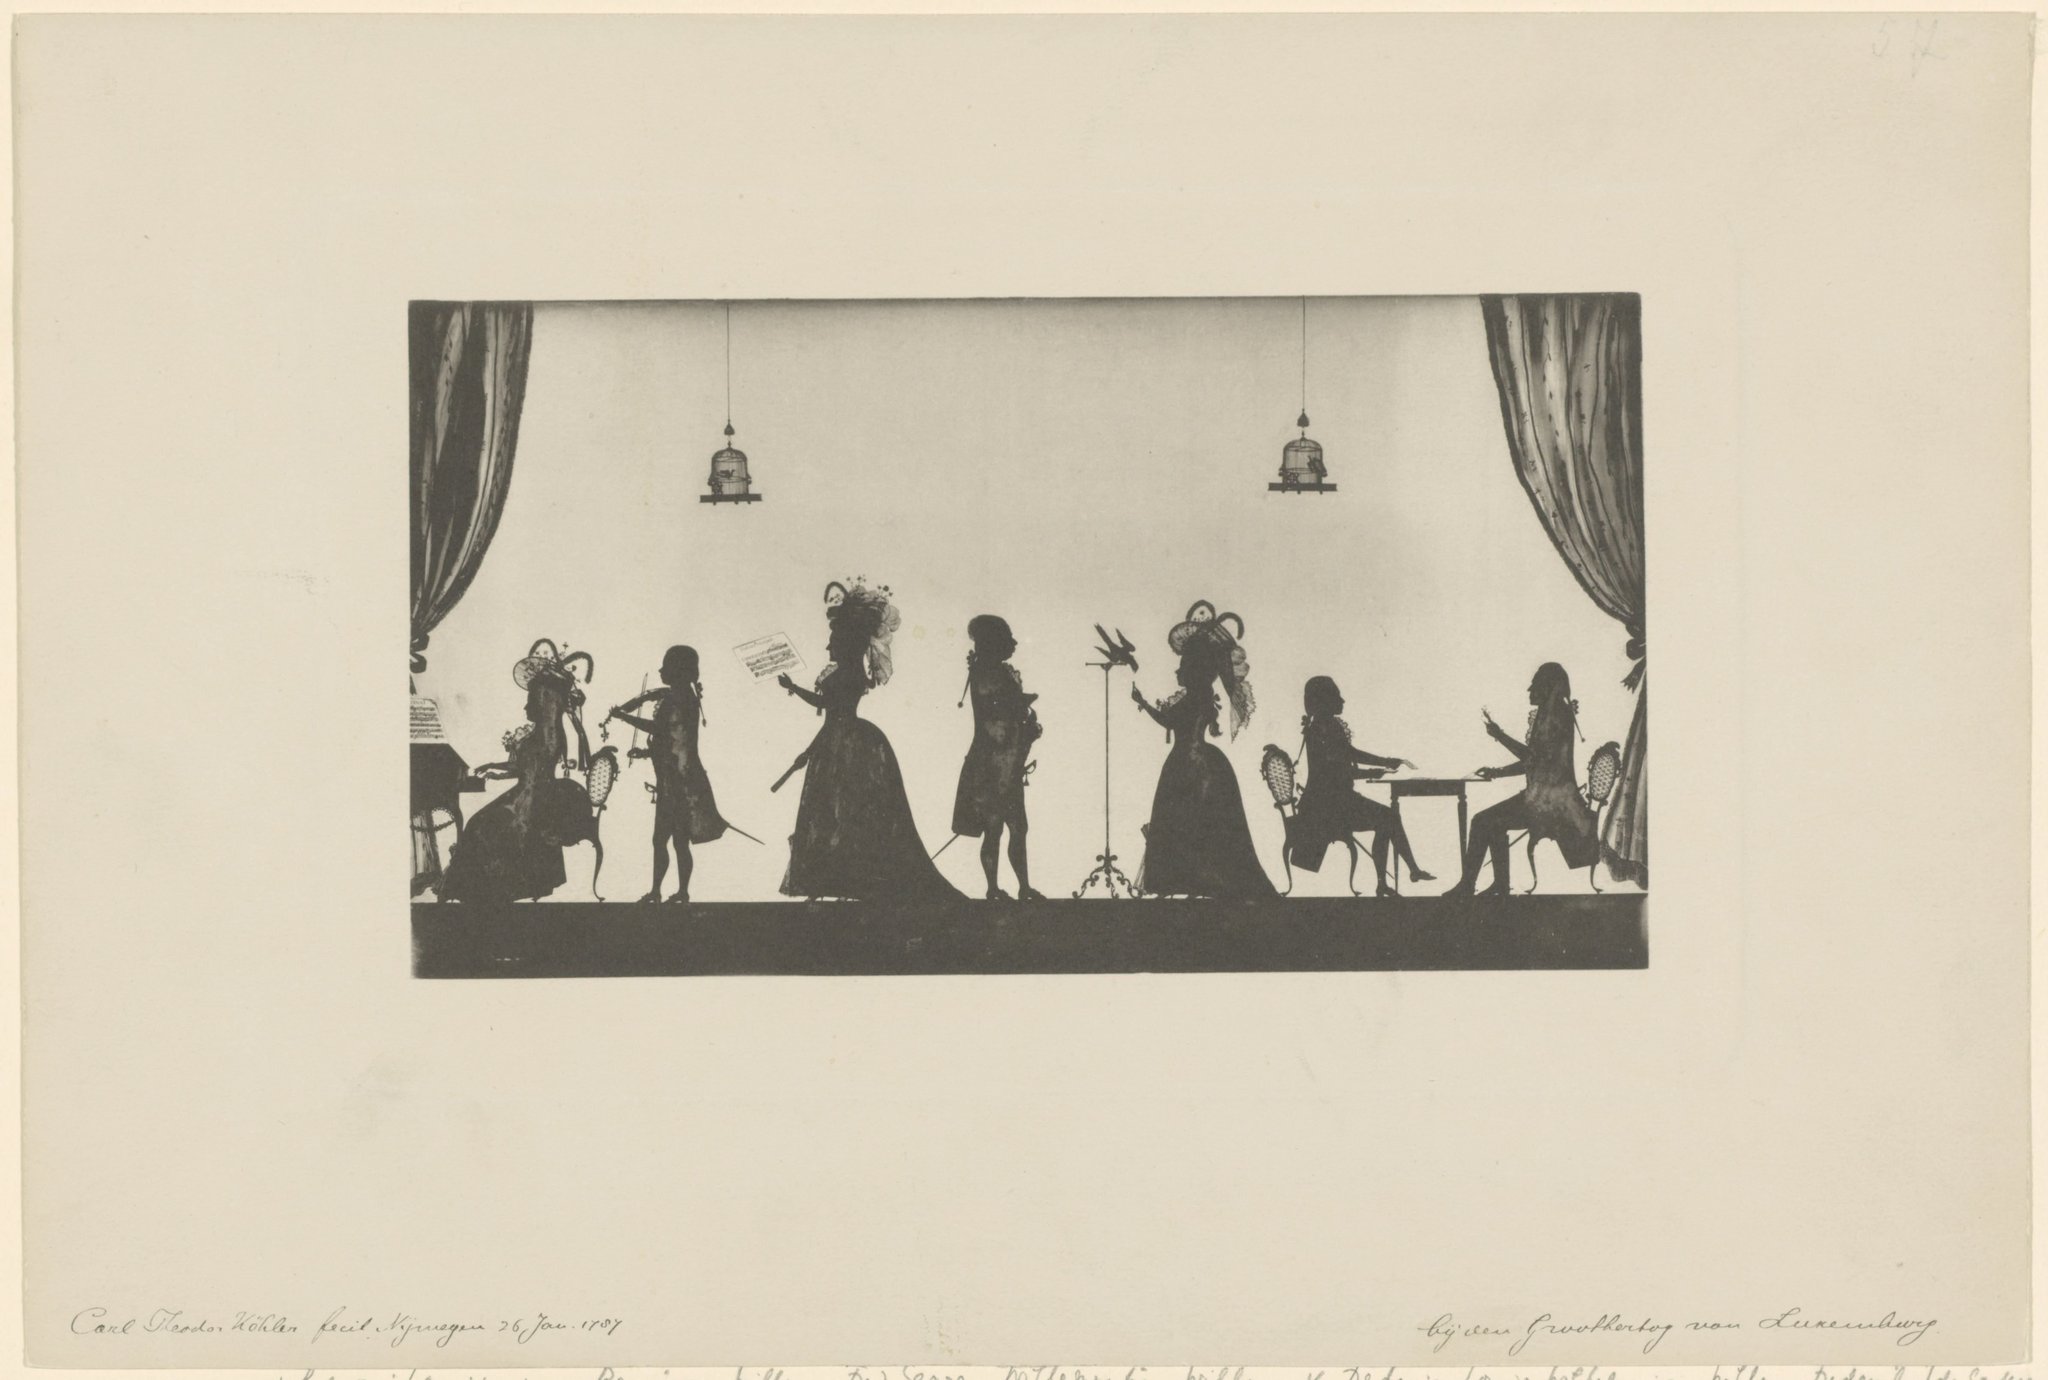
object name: photomechanical print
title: Silhouetportret van Willem V, prins van Oranje-Nassau, Wilhelmina van Pruisen, Louise, prinses van Oranje-Nassau, Willem I Frederik, koning der Nederlanden, en Frederik, prins van Oranje-Nassau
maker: Anonymous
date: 1850-1949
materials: paper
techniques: photograph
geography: netherlands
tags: william v (prince of orange), the hague, berlin, william i of the netherlands, painter, wilhelmina of prussia (princess of orange), amsterdam, louise (prinses van oranje-nassau), willem george frederik (prins van oranje-nassau)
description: De hier vermelde titel verwijst naar de hoogst verkregen titel van de geportretteerde, niet per se naar de titel die de geportretteerde op deze voorstelling draagt.